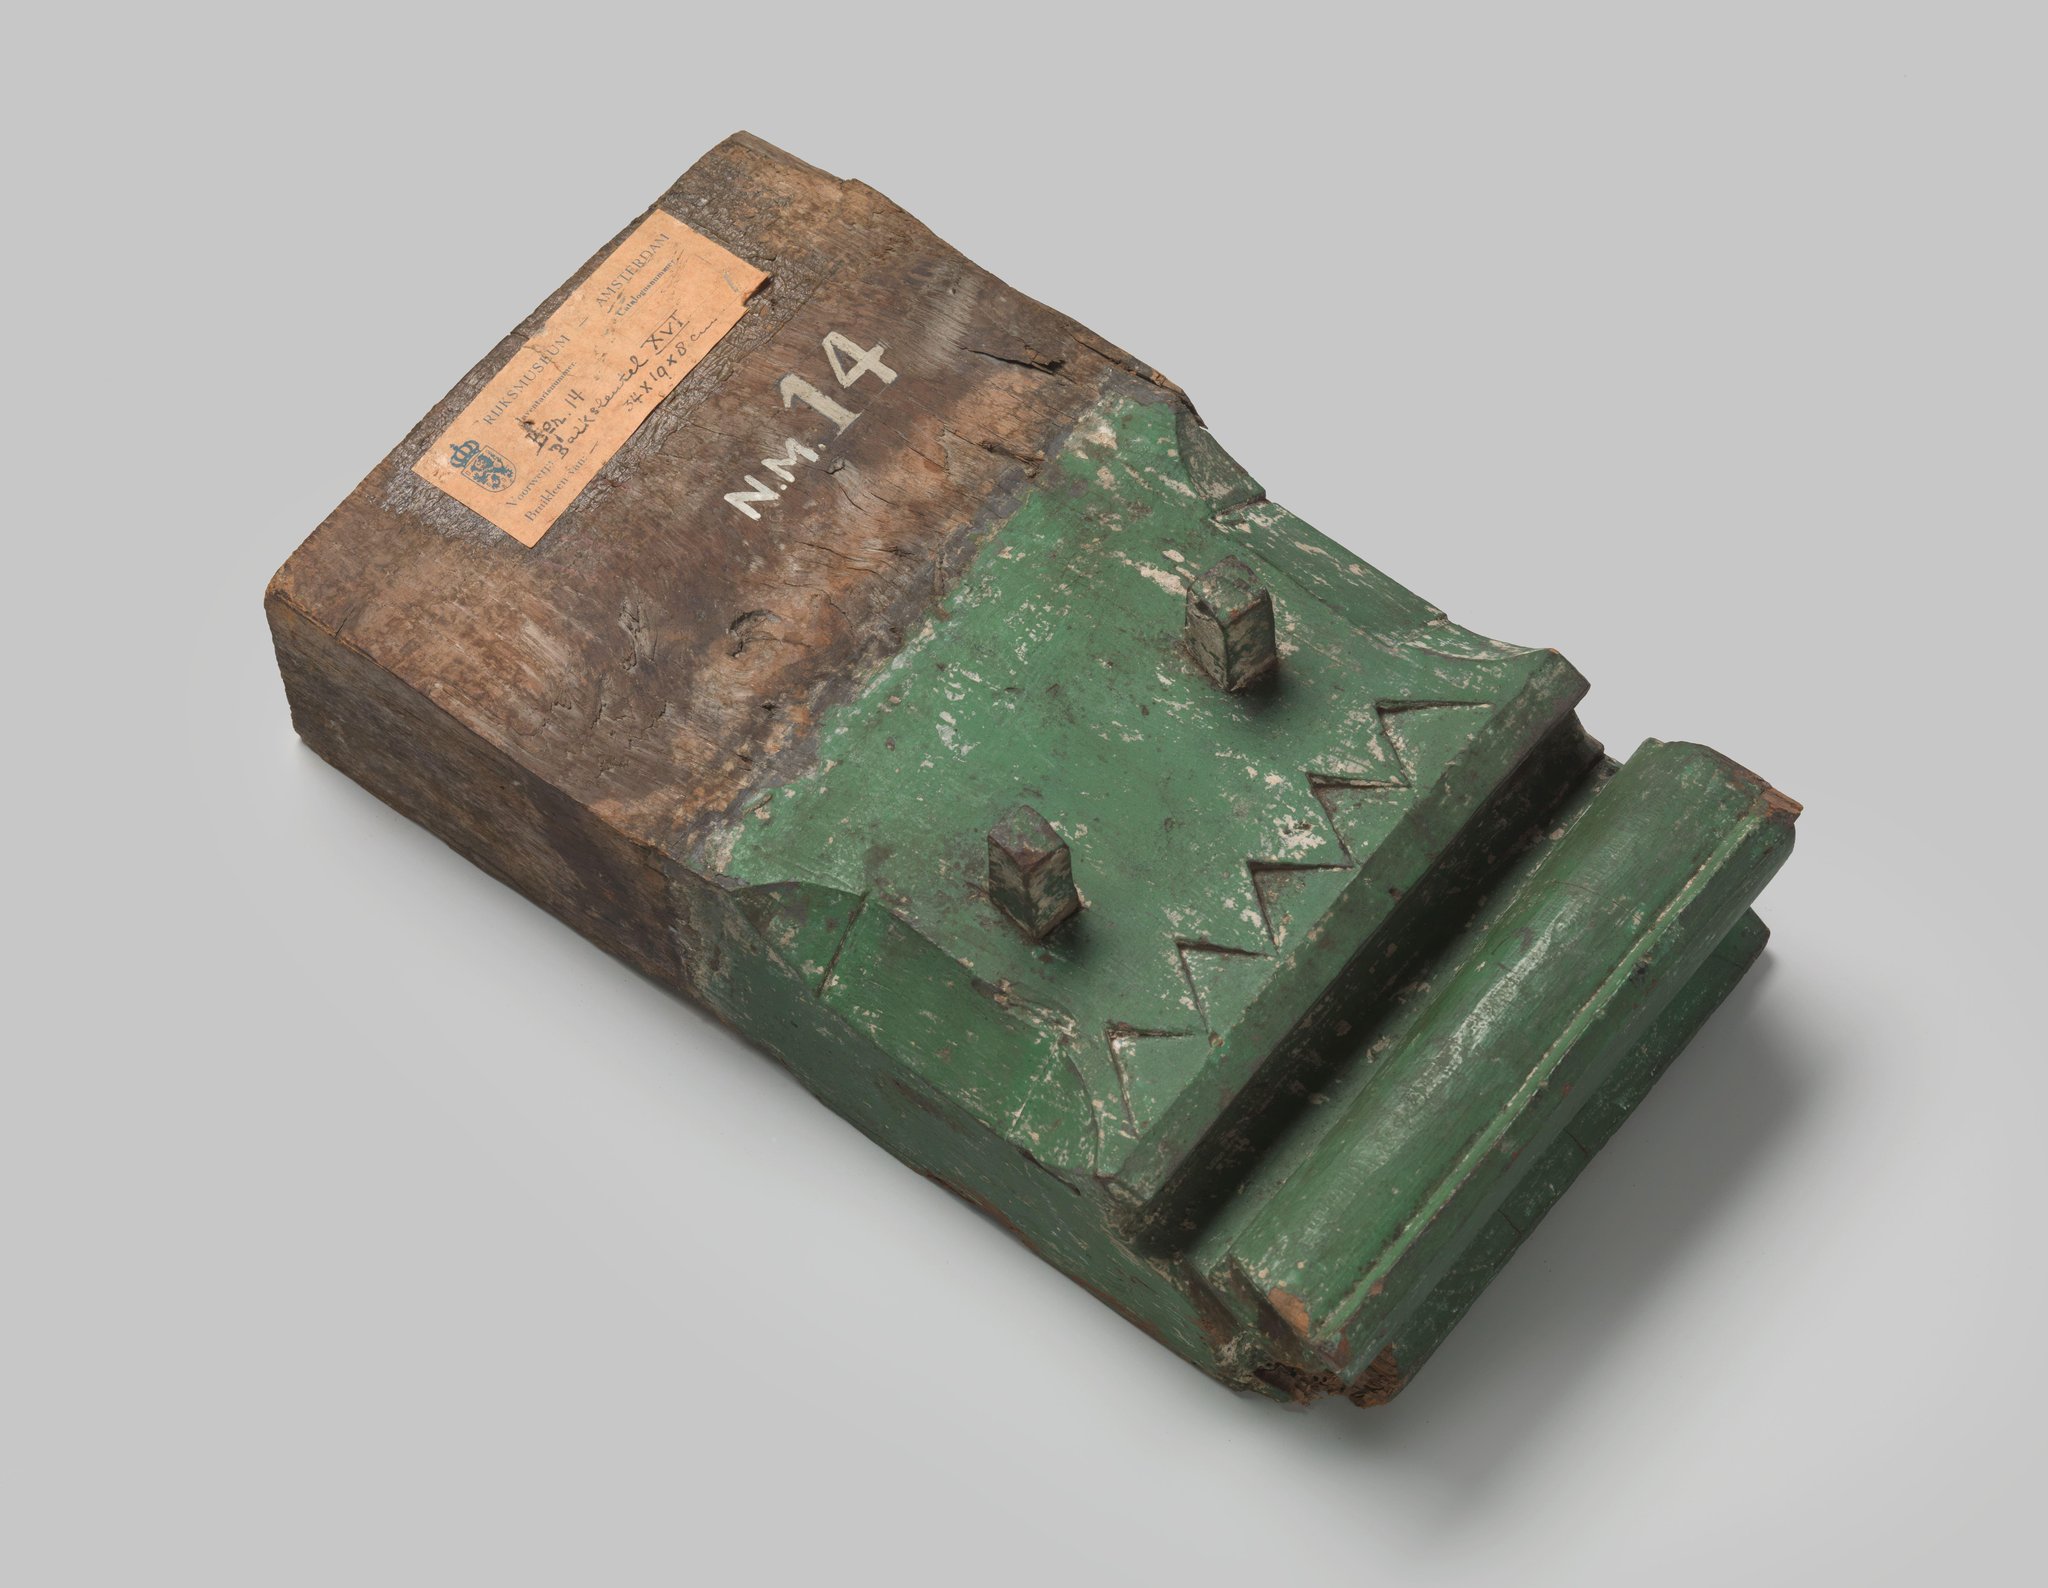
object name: balksleutel, sleutelstuk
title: Sleutelstuk met gotisch lijstwerk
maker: Anonymous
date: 1400-1950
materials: iron, wood, paint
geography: northern netherlands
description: Sleutelstuk van eikenhout met gotisch lijstwerk.